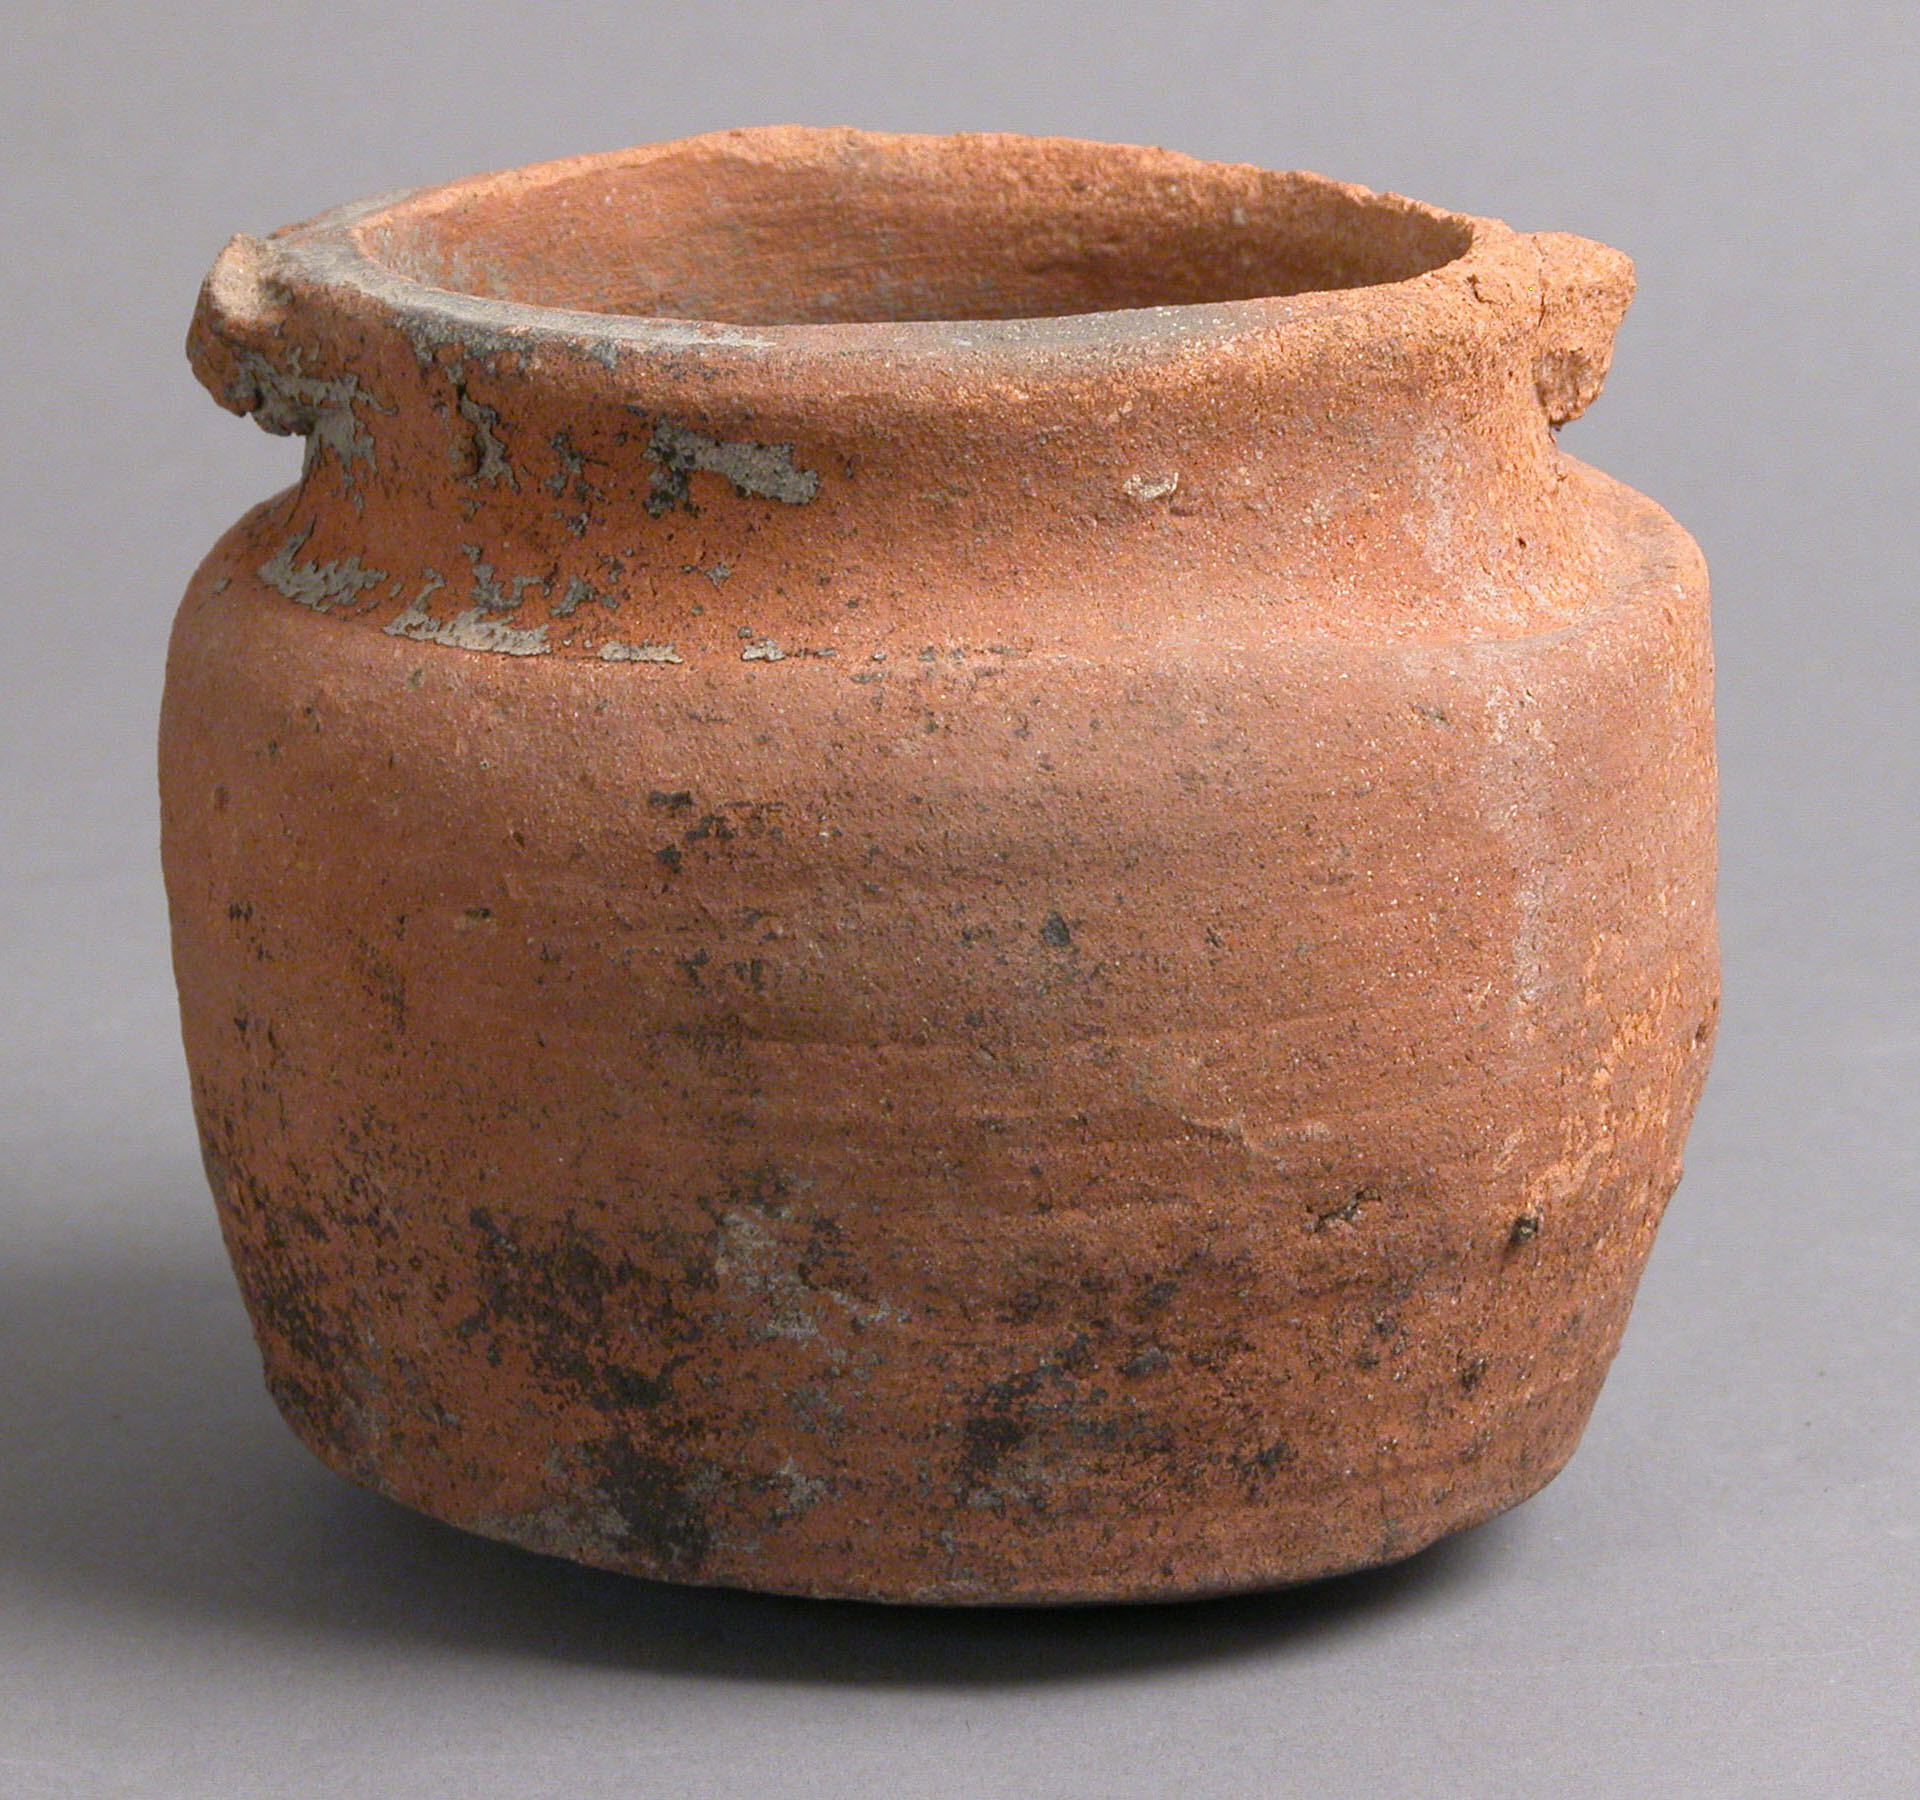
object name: pot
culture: coptic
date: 301-700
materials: earthenware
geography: egypt